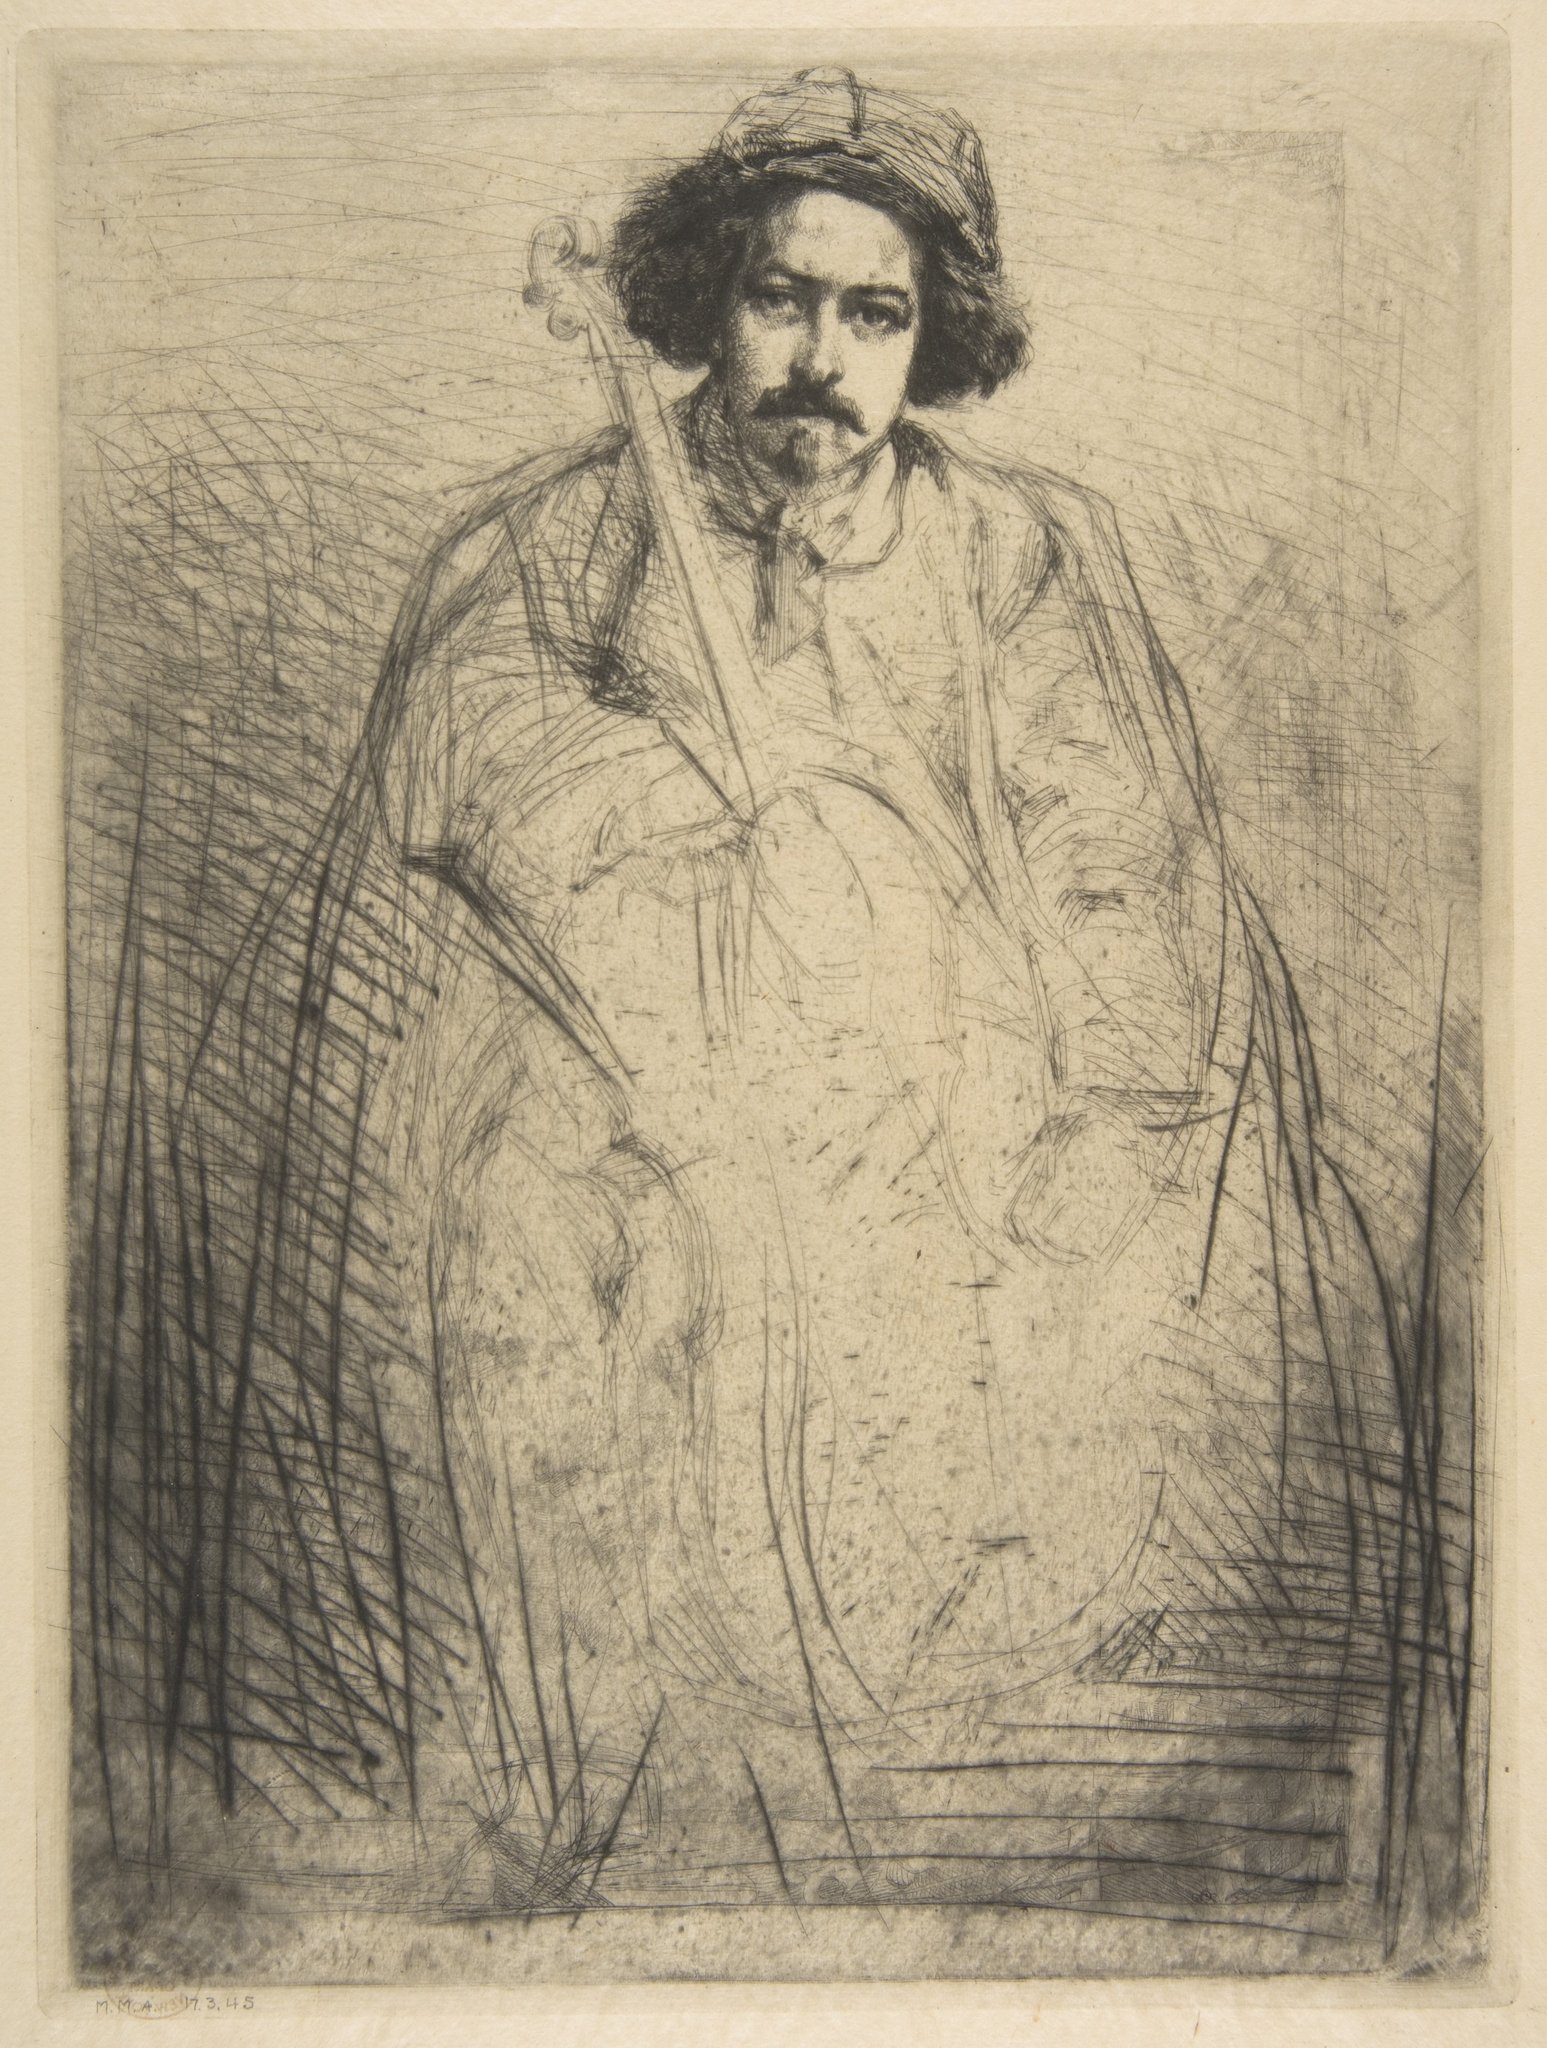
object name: print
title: Becquet (J. Becquet, Sculptor)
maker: james mcneill whistler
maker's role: artist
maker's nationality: american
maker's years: 1834-1903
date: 1859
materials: ink, ivory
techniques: drypoint, etching, printing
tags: men,violas